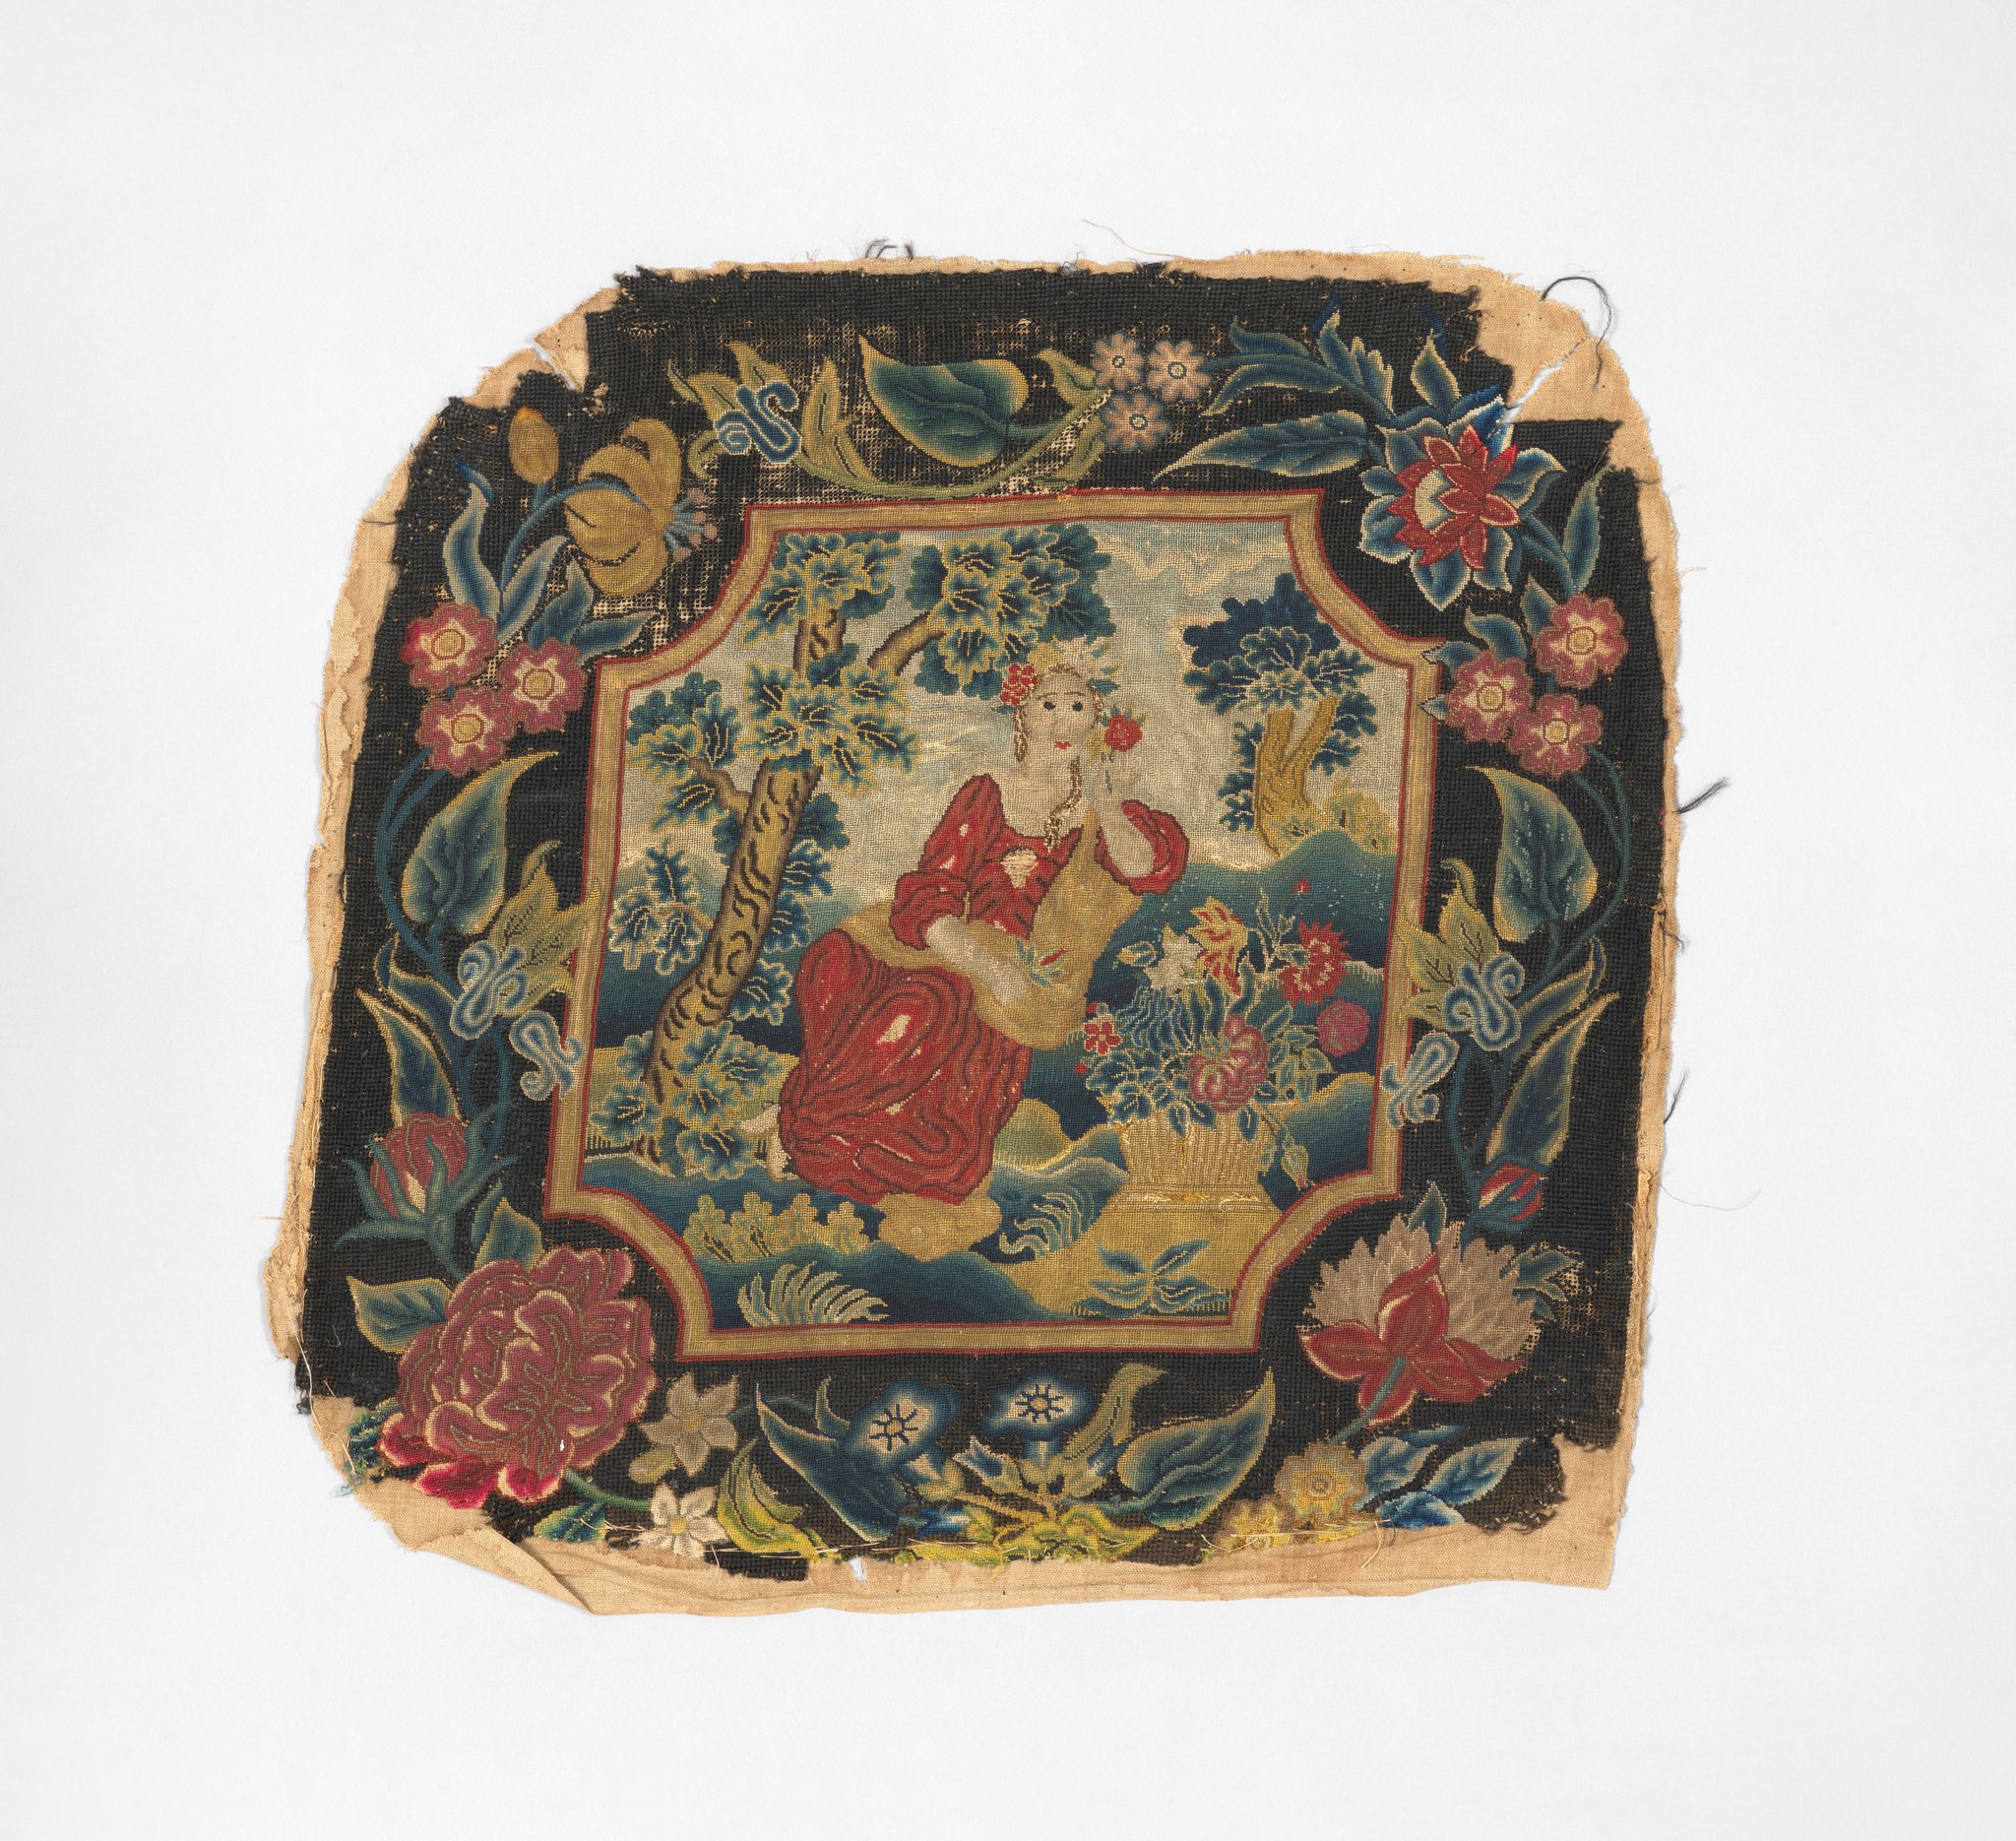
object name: cover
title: Chair seat cover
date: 1734-1766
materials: canvas, silk, wool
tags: women